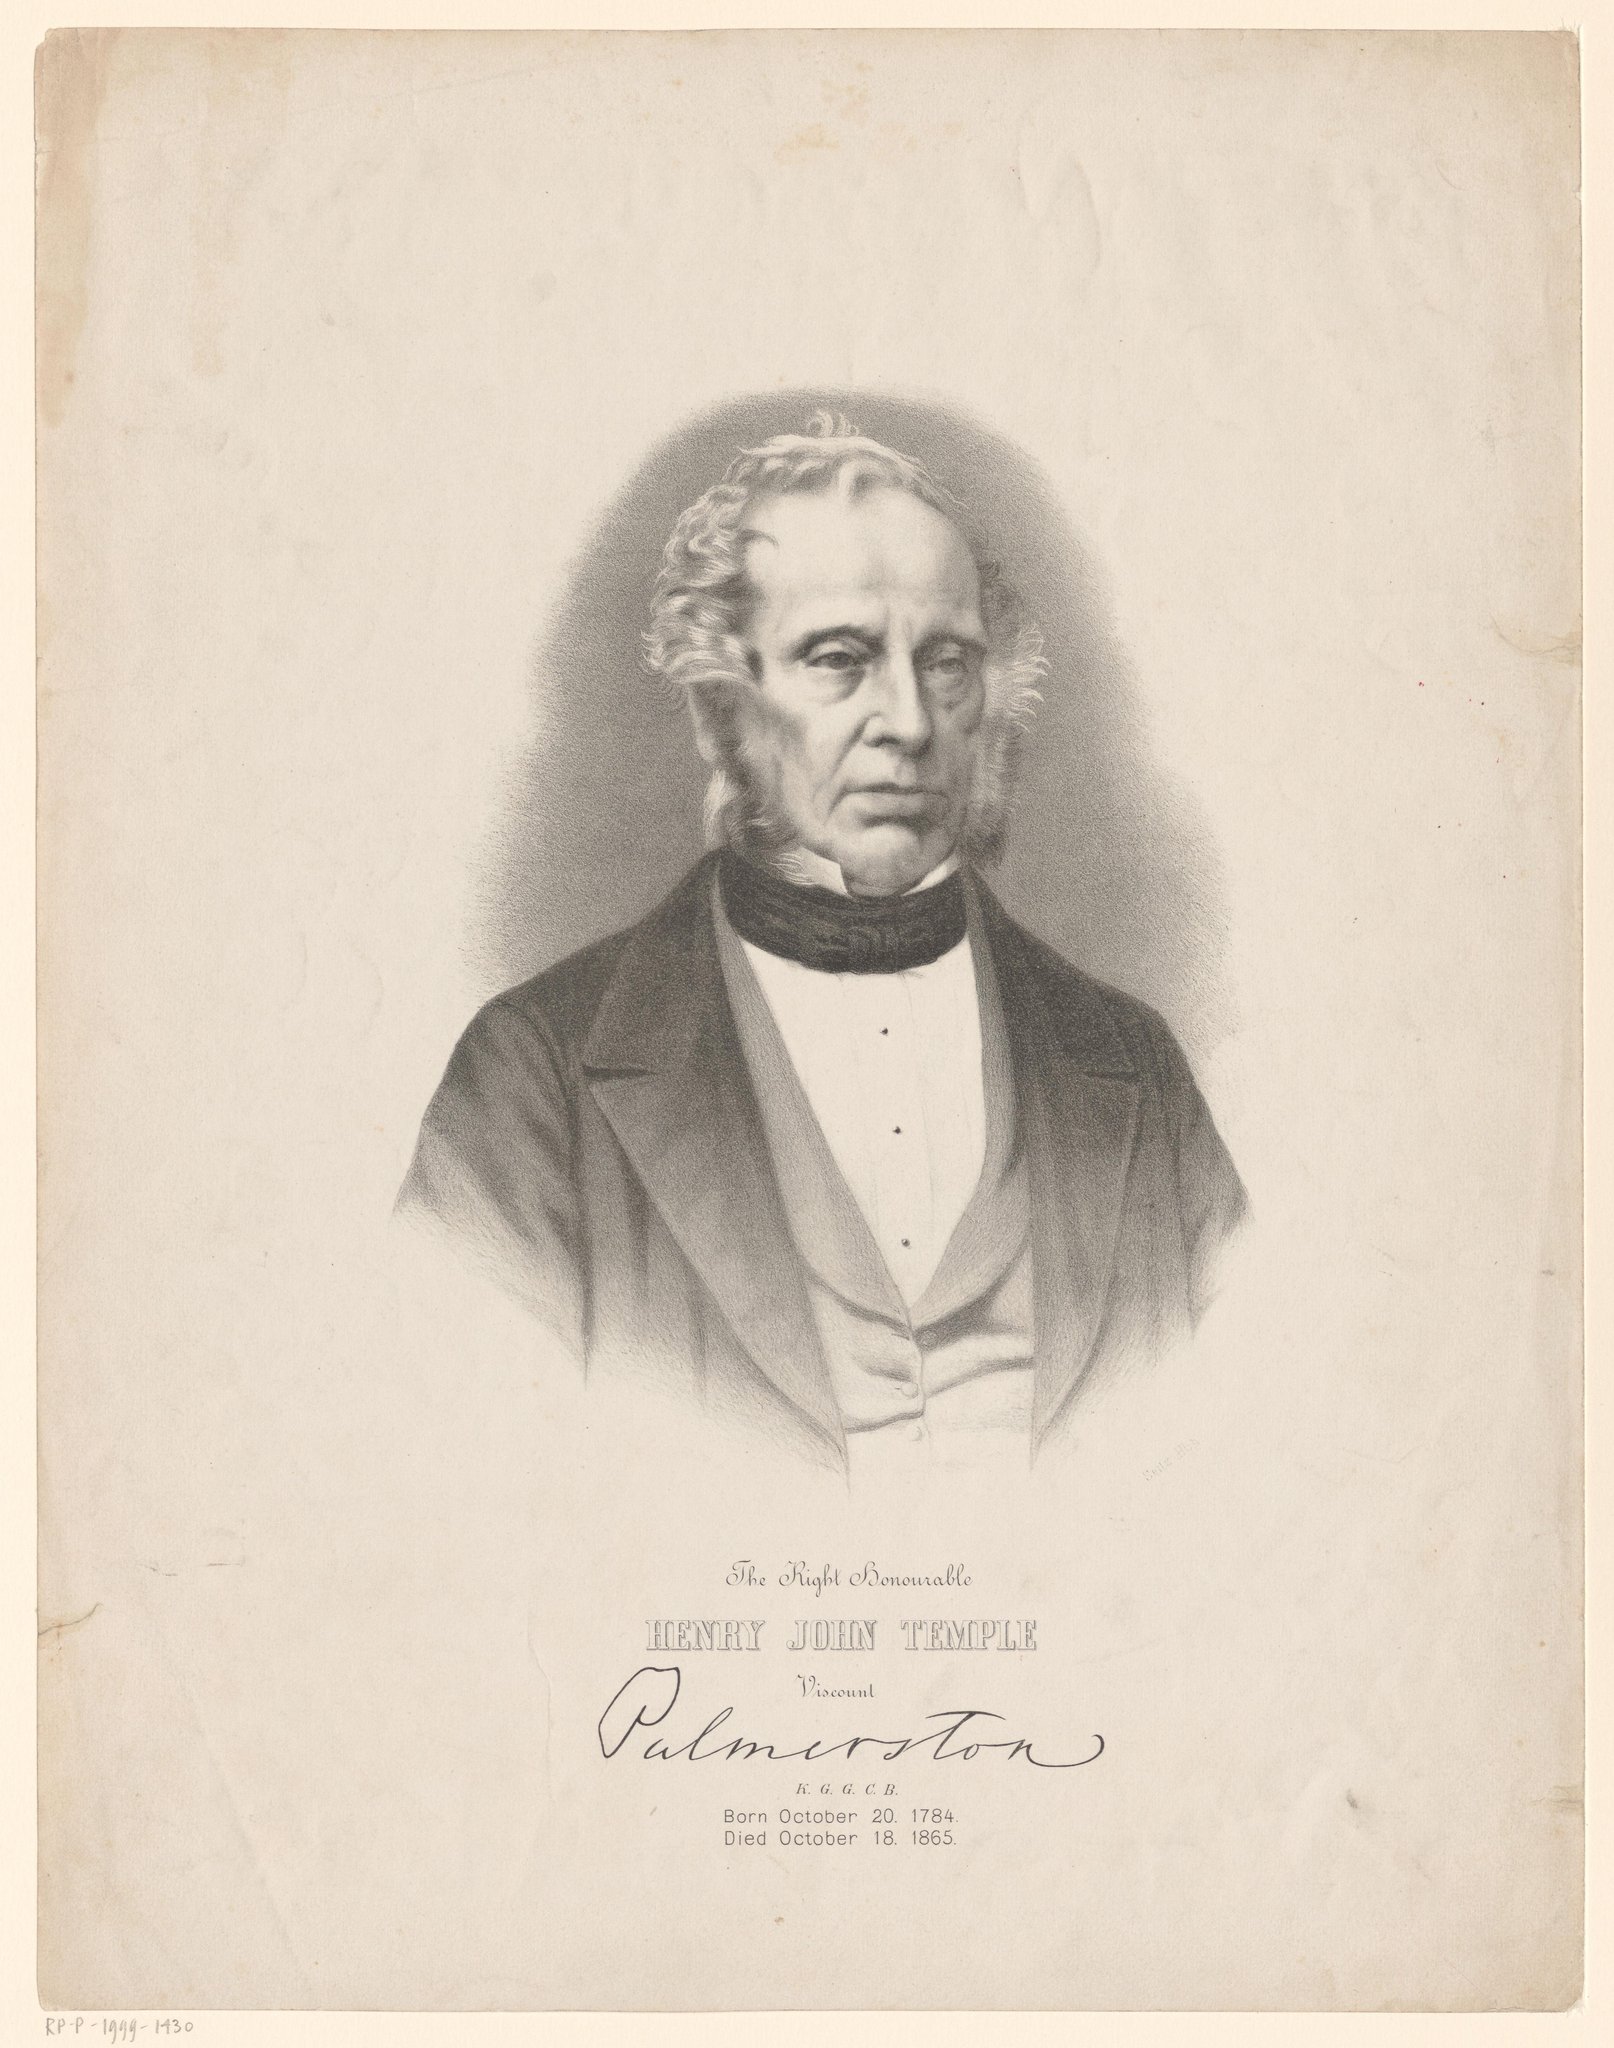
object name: print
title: Portret van Henry John Temple, 3e burggraaf Palmerston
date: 1865-1899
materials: paper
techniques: lithograph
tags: adult man, historical persons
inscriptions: collector's mark: Lugt 2760, collector's mark: Lugt 2228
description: Henry John Temple, 3rd Viscount Palmerston, KG, GCB, PC (20 oktober 1784 – 18 oktober 1865). Brits staatsman; 2x Prime Minister van Engeland in het midden van de negentiende-eeuw. Buste in profiel naar rechts.